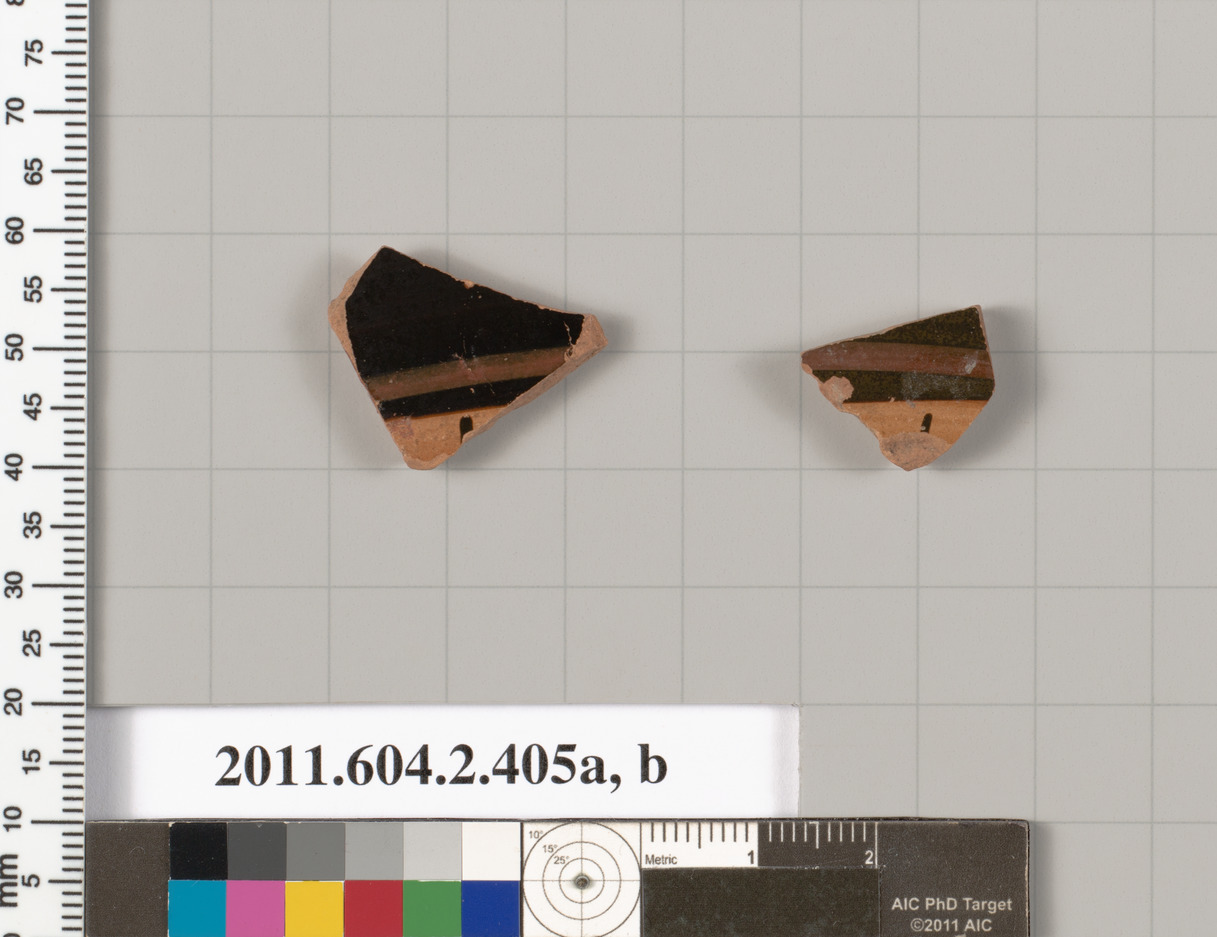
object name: column krater fragment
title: Terracotta fragments of a column-krater (bowl for mixing wine and water)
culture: greek, attic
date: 460-440 BCE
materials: terracotta